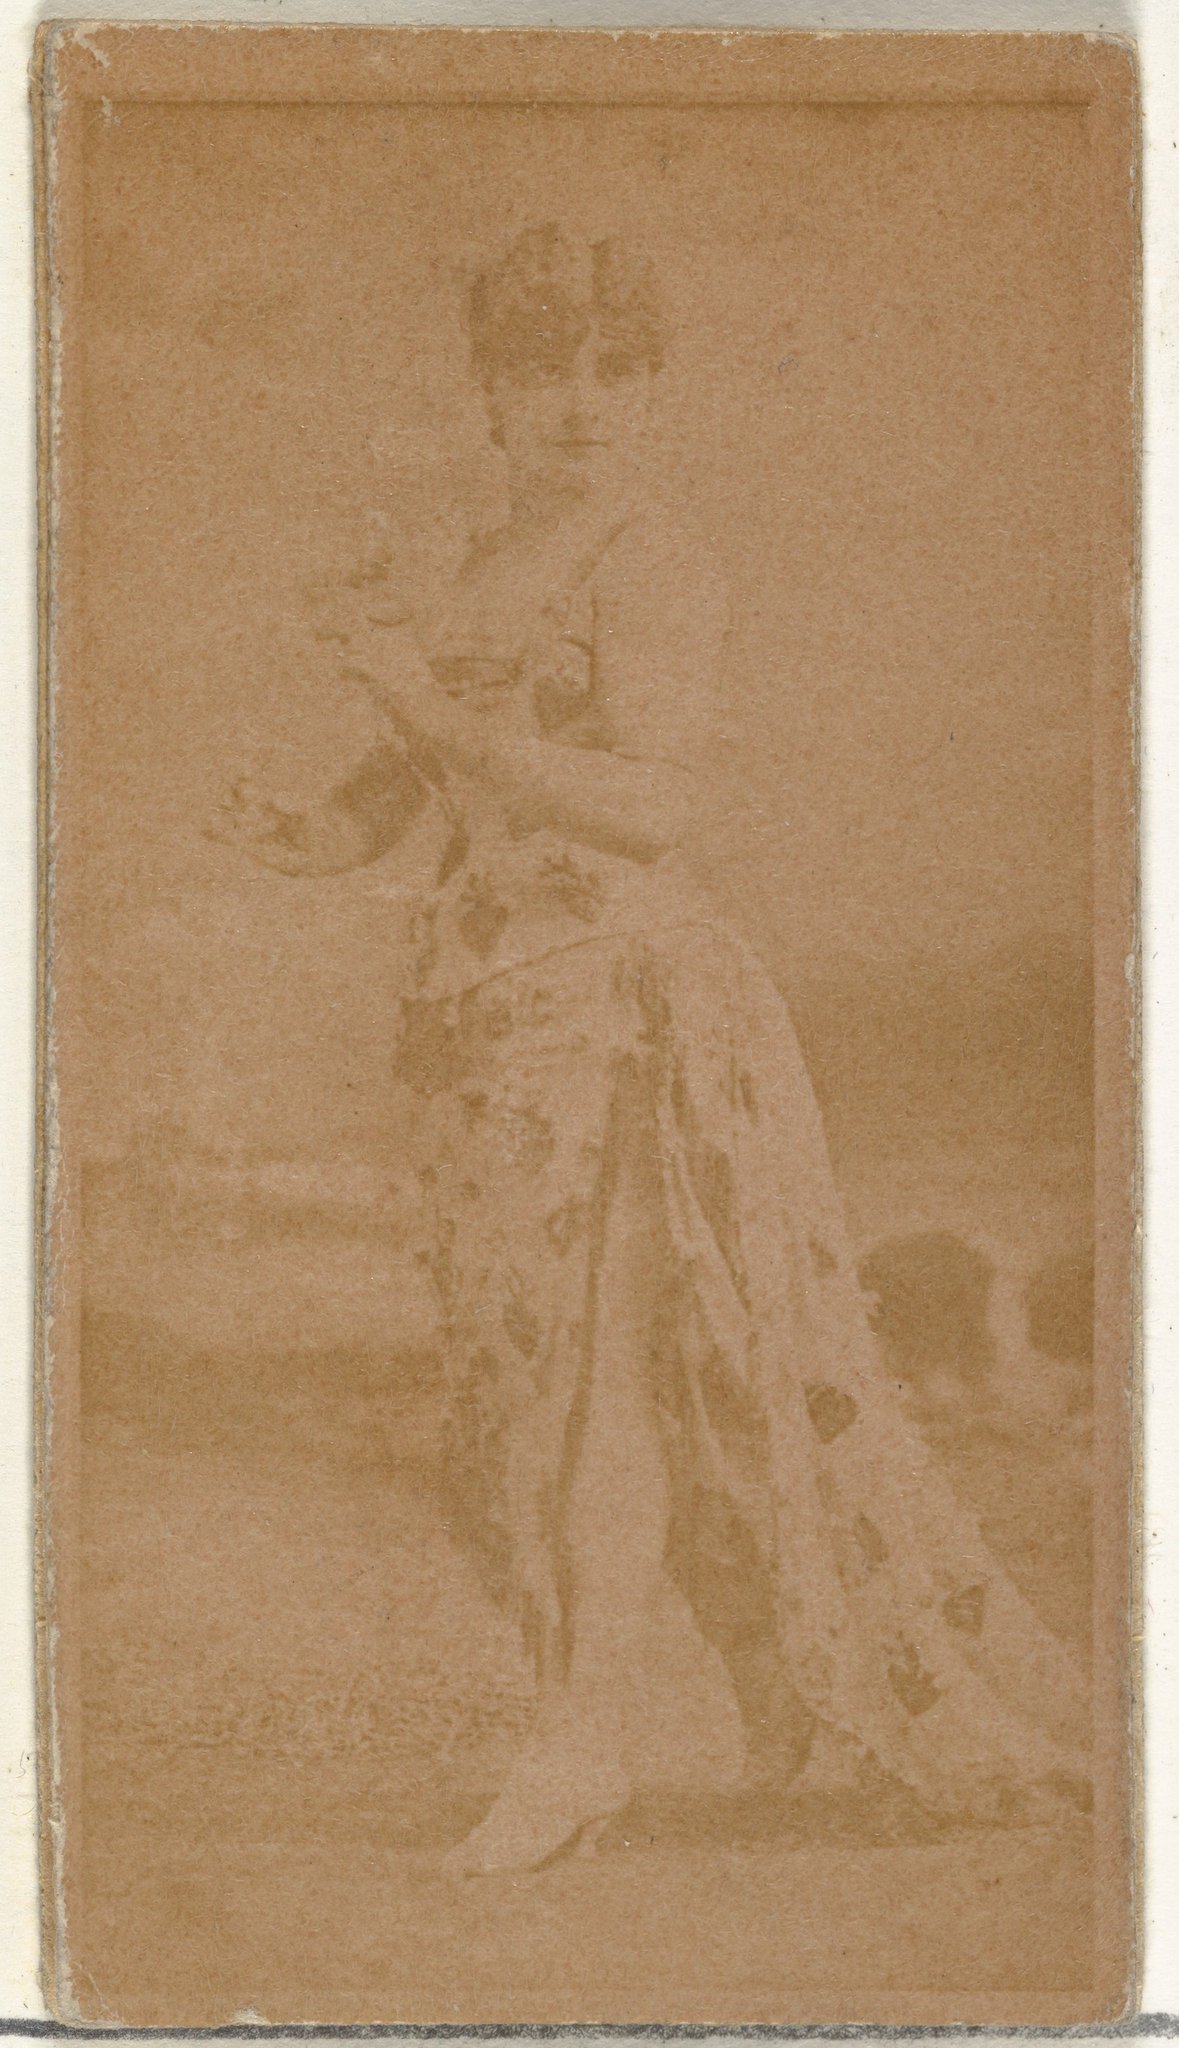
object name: photograph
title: [Actress posing in patterned gown], from the Actors and Actresses series (N145-8) issued by Duke Sons & Co. to promote Duke Cigarettes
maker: w. duke, sons & co.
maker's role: publisher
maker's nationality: american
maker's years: 1870-1920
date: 1891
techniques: albumen silver print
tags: portraits,women,actresses